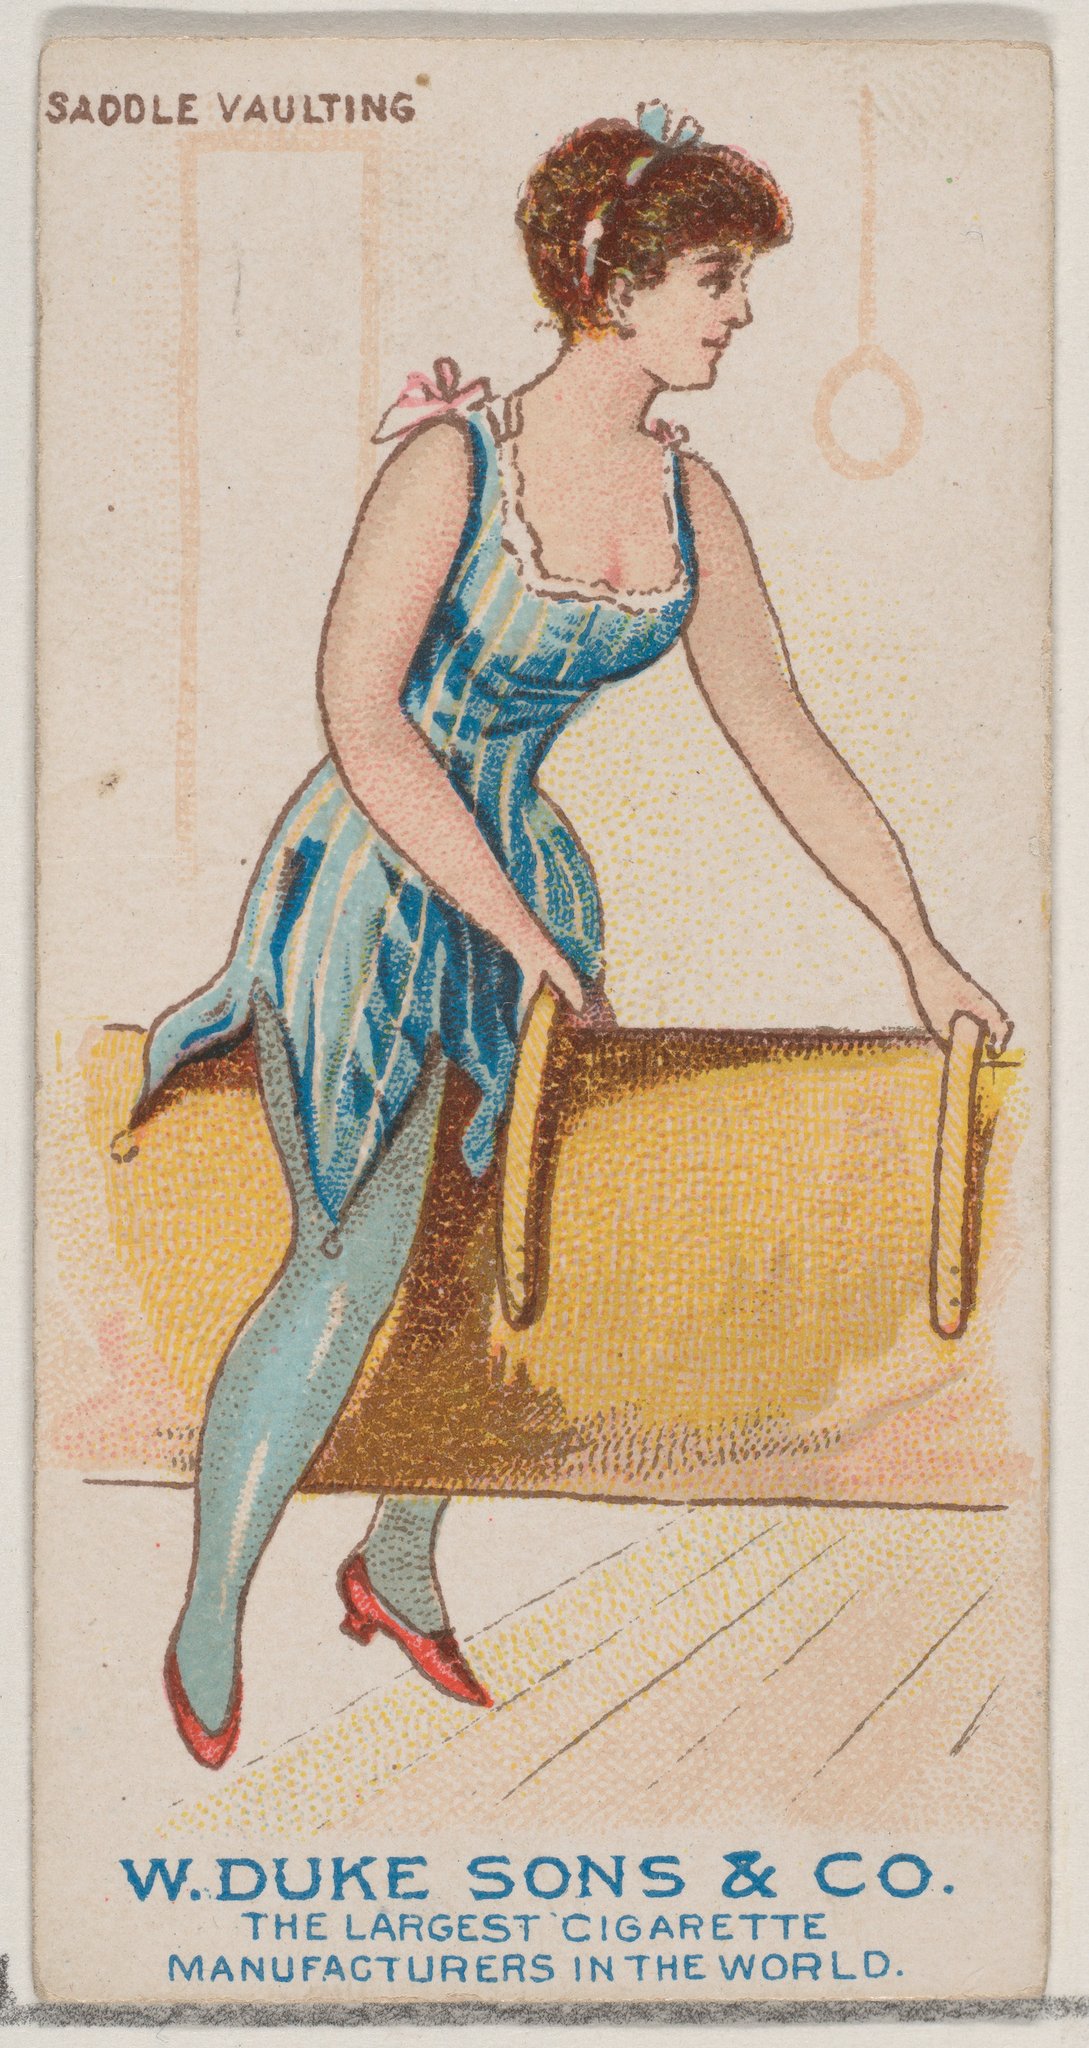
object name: print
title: Saddle Vaulting, from the Gymnastic Exercises series (N77) for Duke brand cigarettes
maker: w. duke, sons & co.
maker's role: publisher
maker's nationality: american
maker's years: 1870-1920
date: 1887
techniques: color lithograph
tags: women,sports,athletes